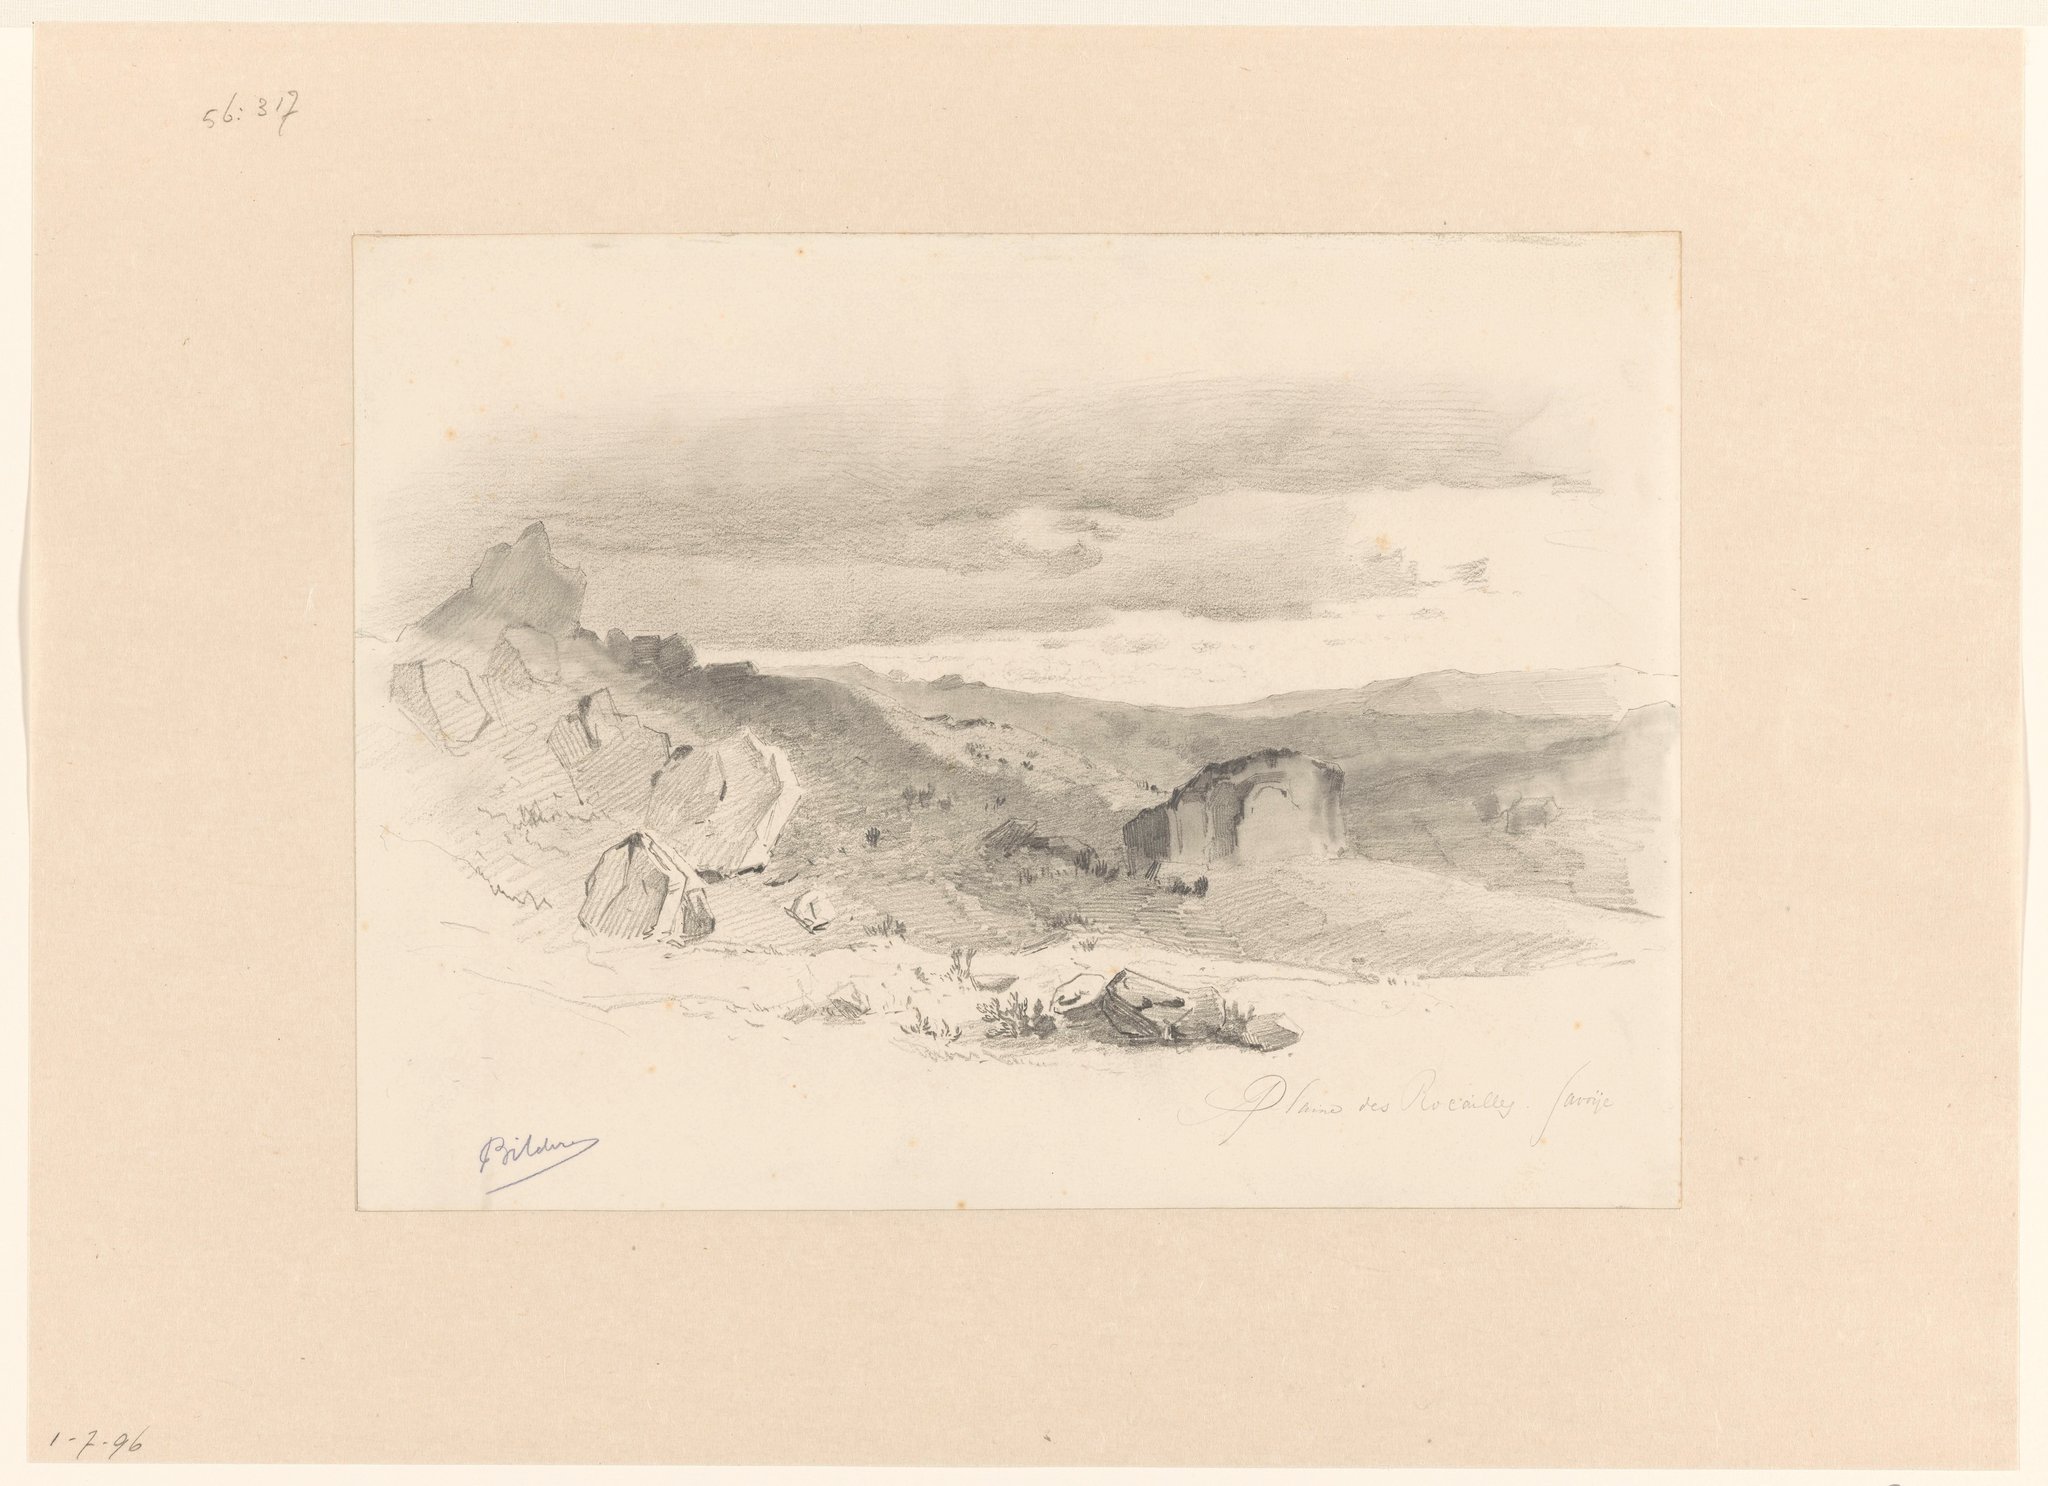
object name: drawing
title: Heuvellandschap Plaine des Rocailles in Savoije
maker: gerard bilders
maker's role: draughtsman, print maker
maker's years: 1838-1865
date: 1848-1865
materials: paper, pencil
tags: low hill country, france